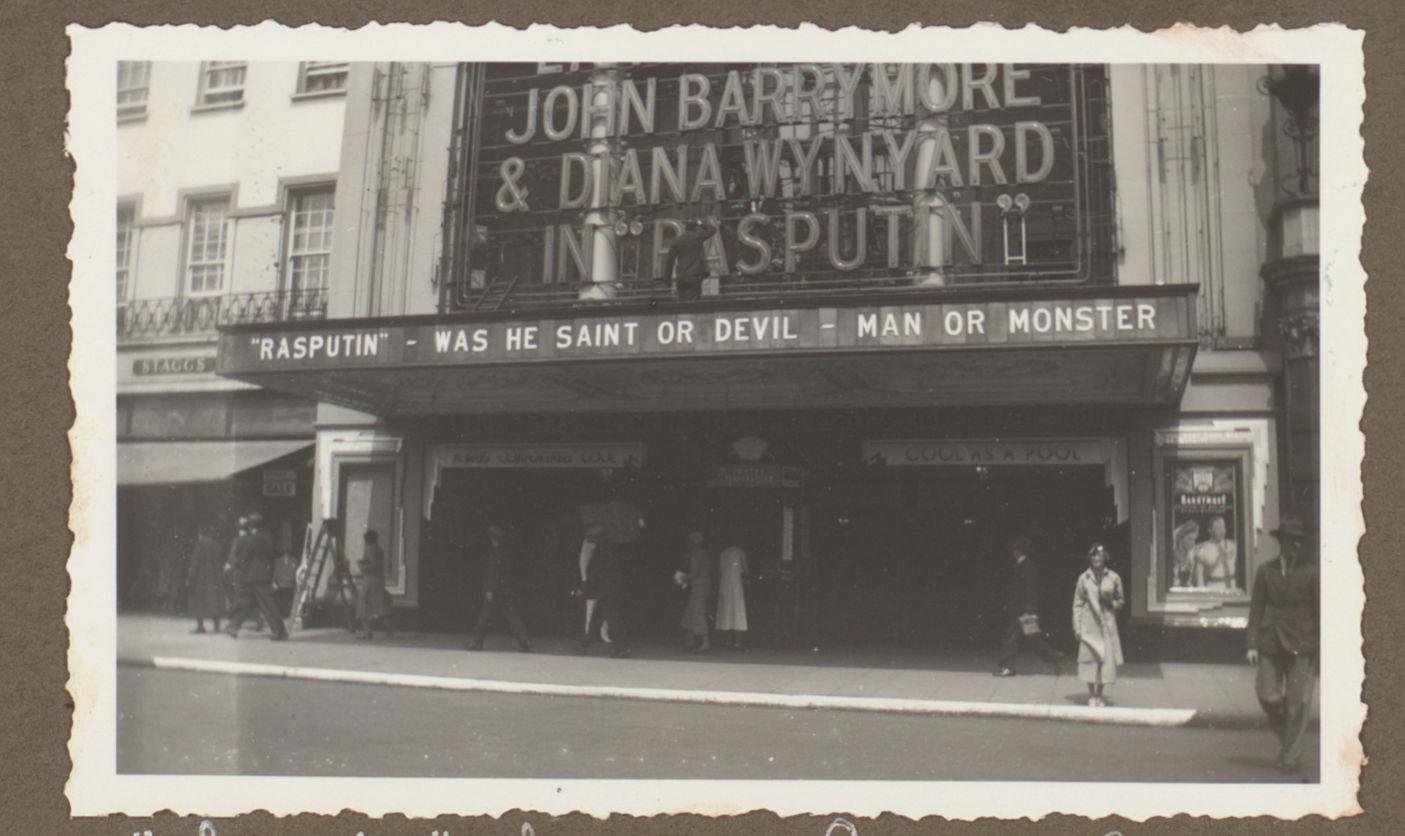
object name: photograph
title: Bioscoop Empire op Leicester Square, Londen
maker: Anonymous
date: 1906-1933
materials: paper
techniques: gelatin silver print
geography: london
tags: cinema, movie-house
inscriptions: inscription: ‘"Empire" bioscoop Leicester Square’